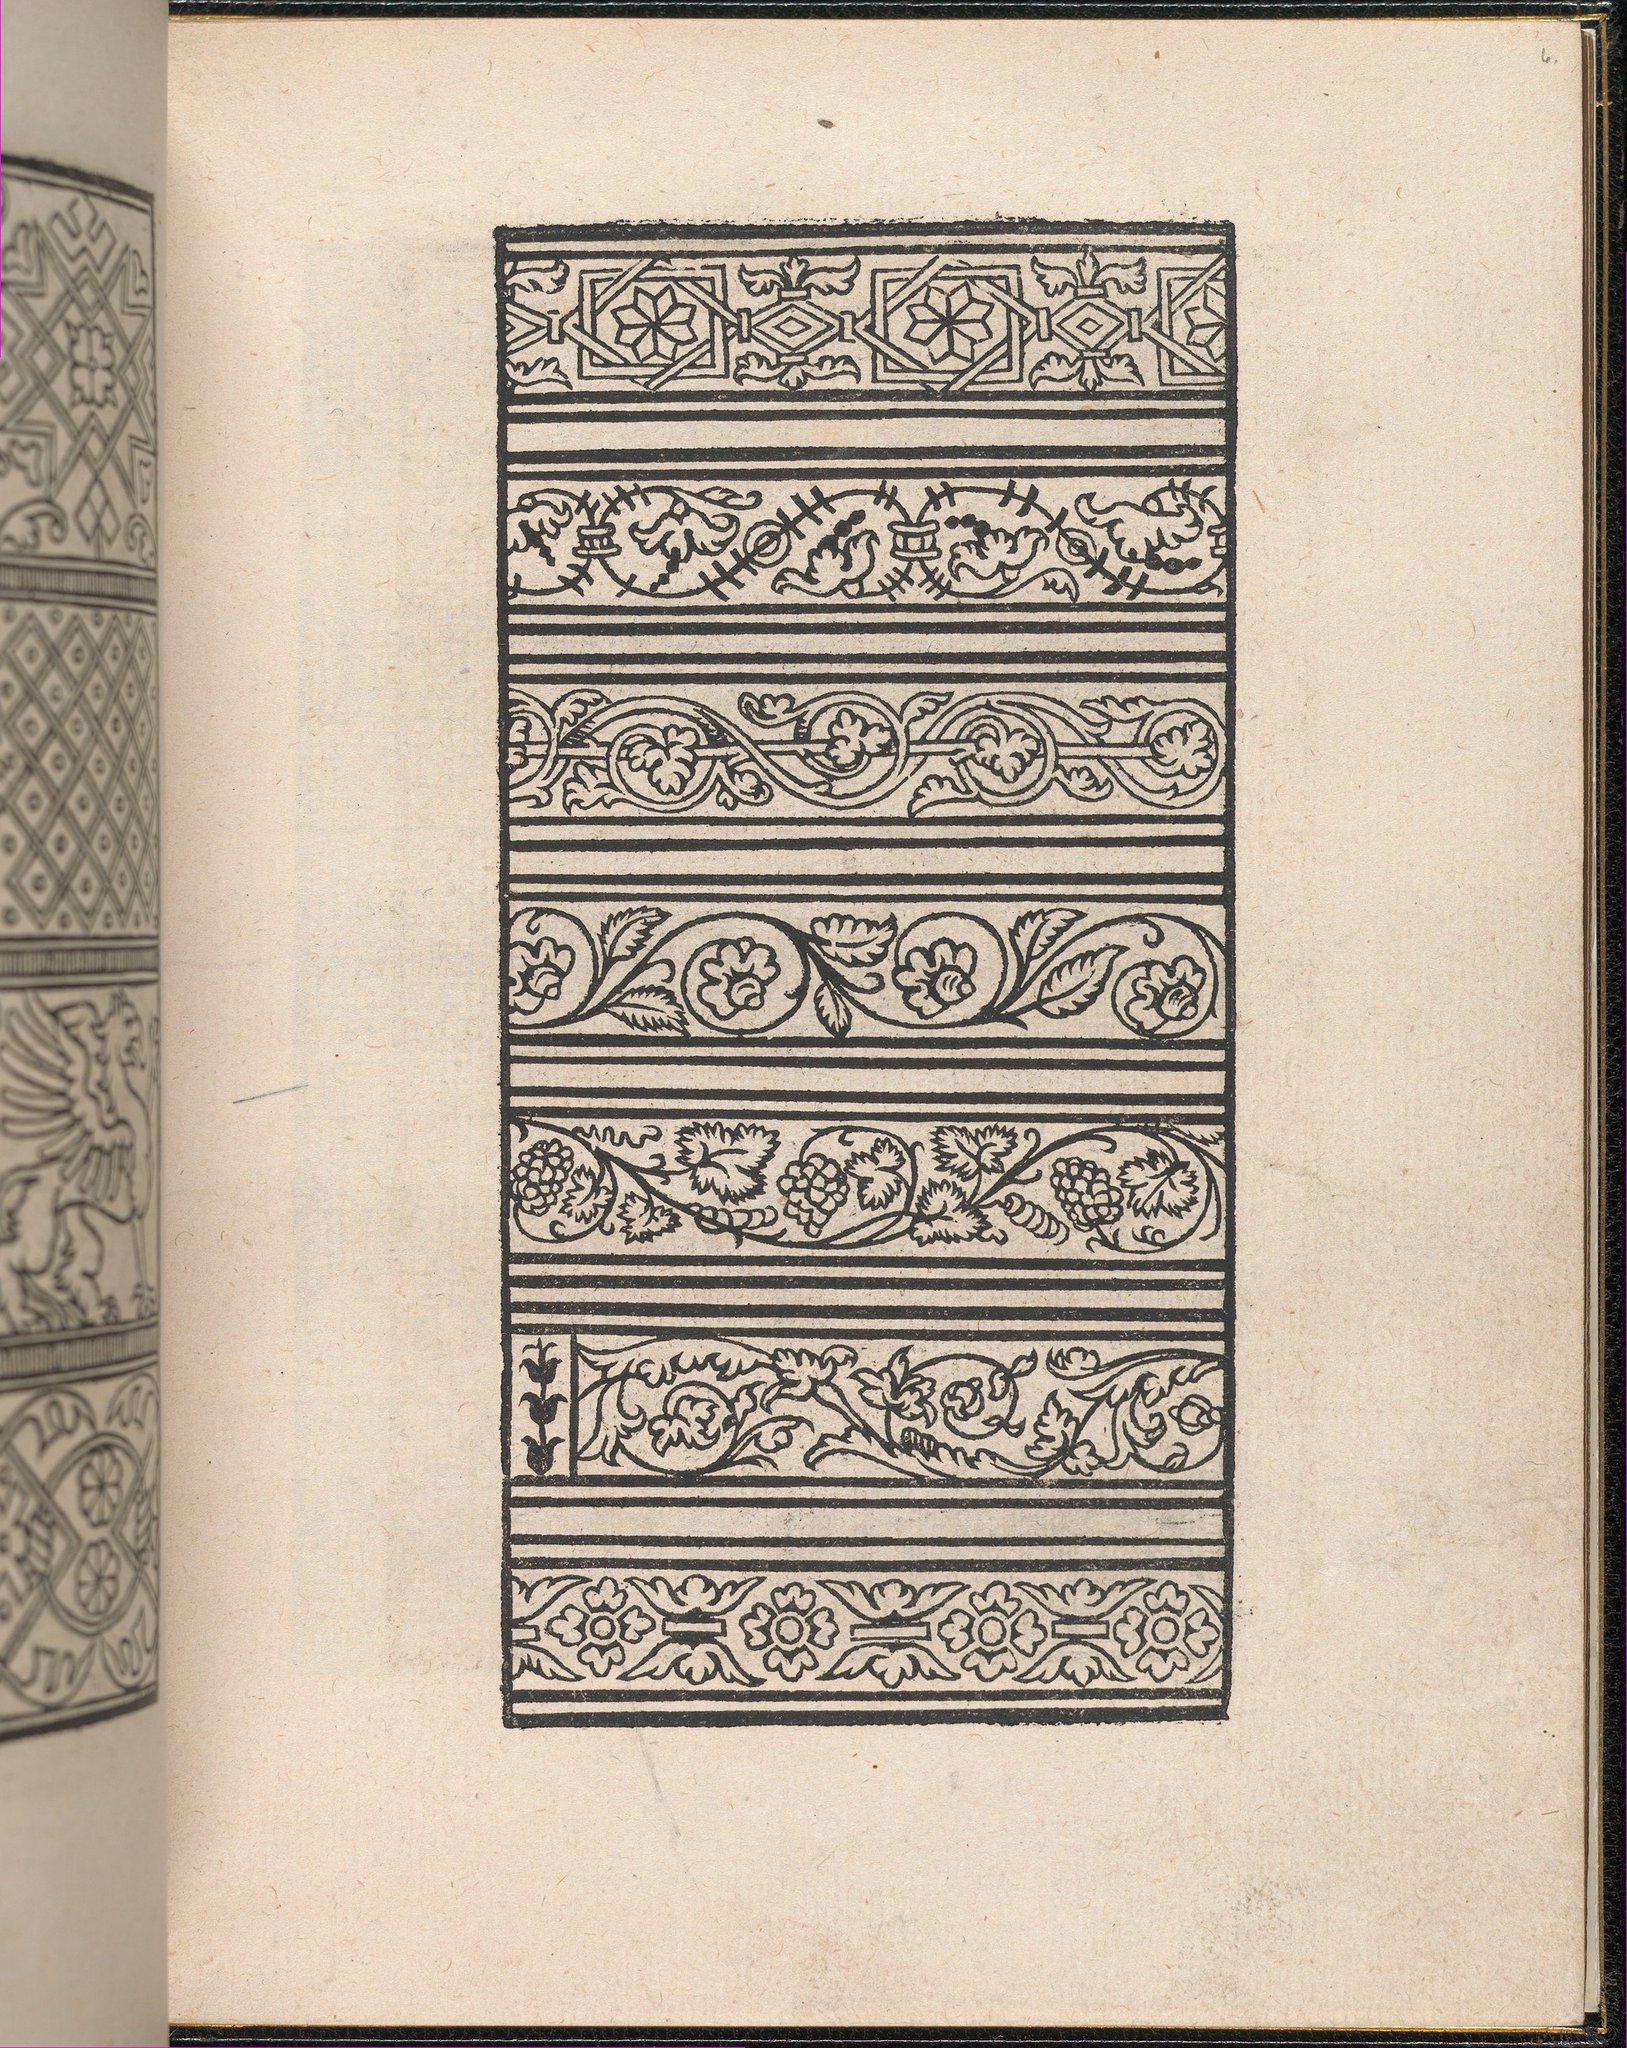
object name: book print ornament architecture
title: Page from Ein new kunstlich Modelbuch...(Page 6r)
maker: peter quentel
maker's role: publisher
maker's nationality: german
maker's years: 1500-1550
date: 1544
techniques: woodcut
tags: ornament